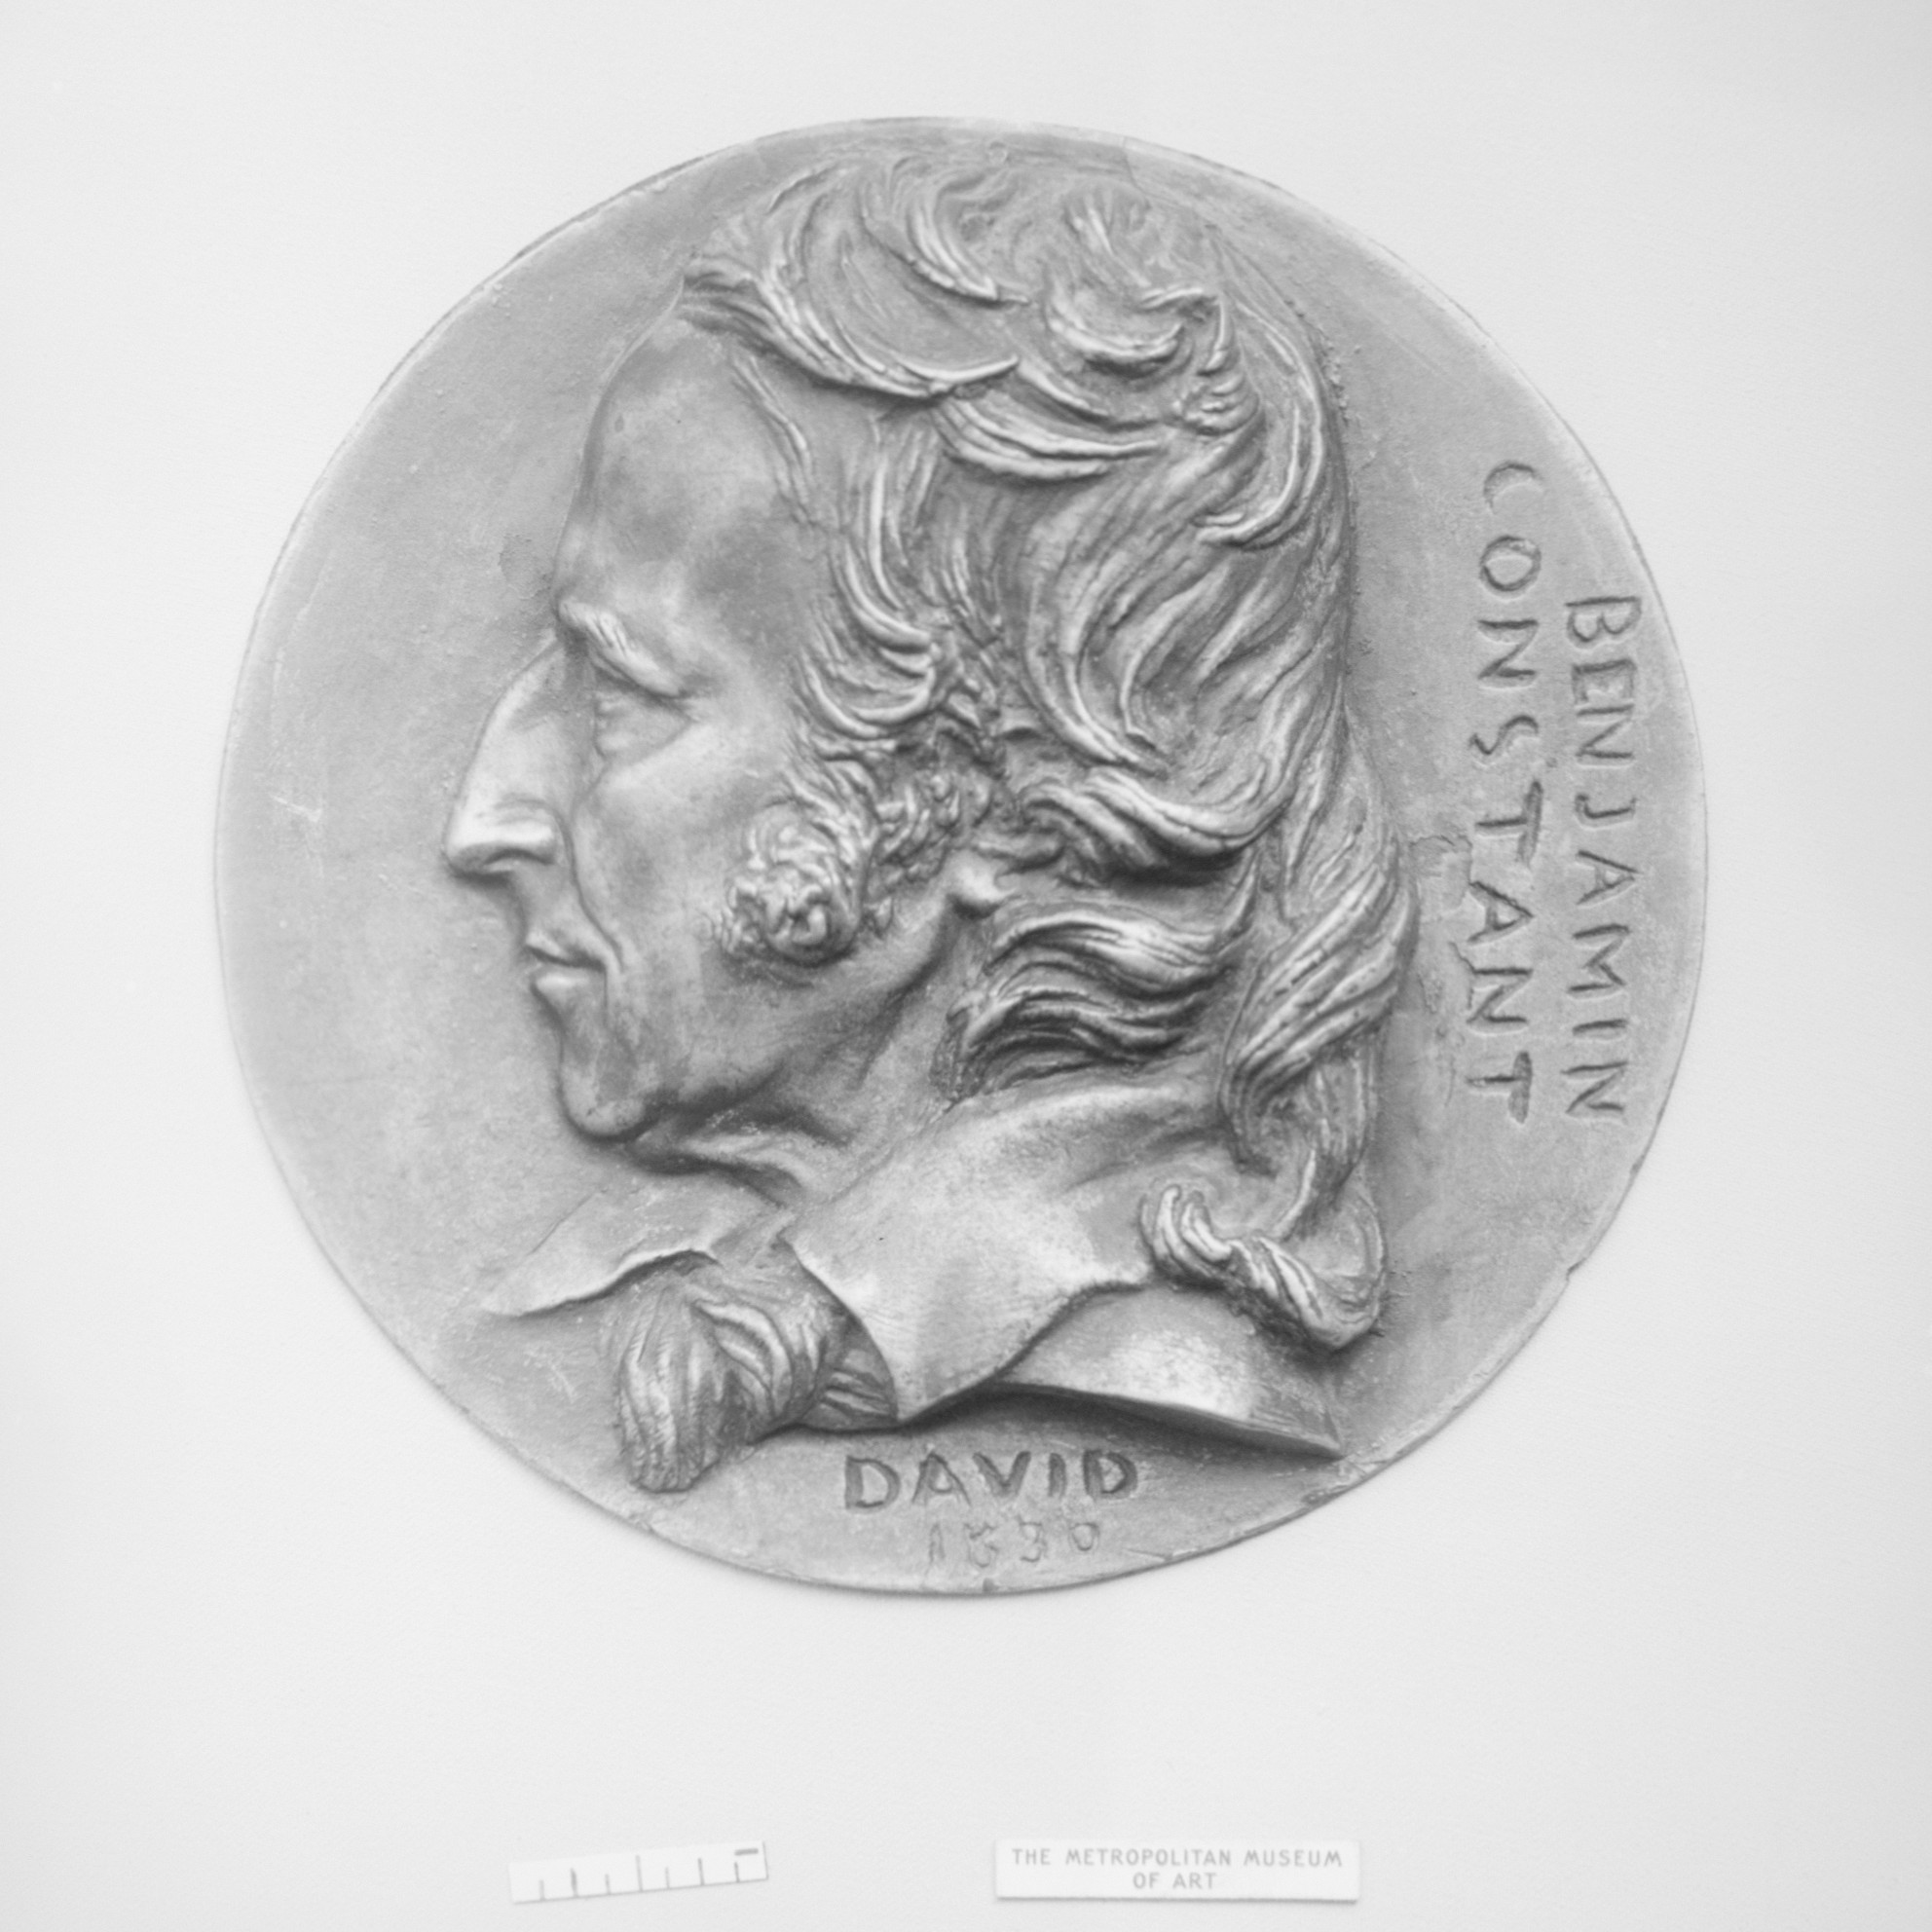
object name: medallion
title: Henri Benjamin Constant de Rebecque (1767–1830), Swiss-French political writer and politician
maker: pierre jean david d'angers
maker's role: artist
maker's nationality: french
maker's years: 1788-1856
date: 1830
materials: bronze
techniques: casting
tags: men,profiles